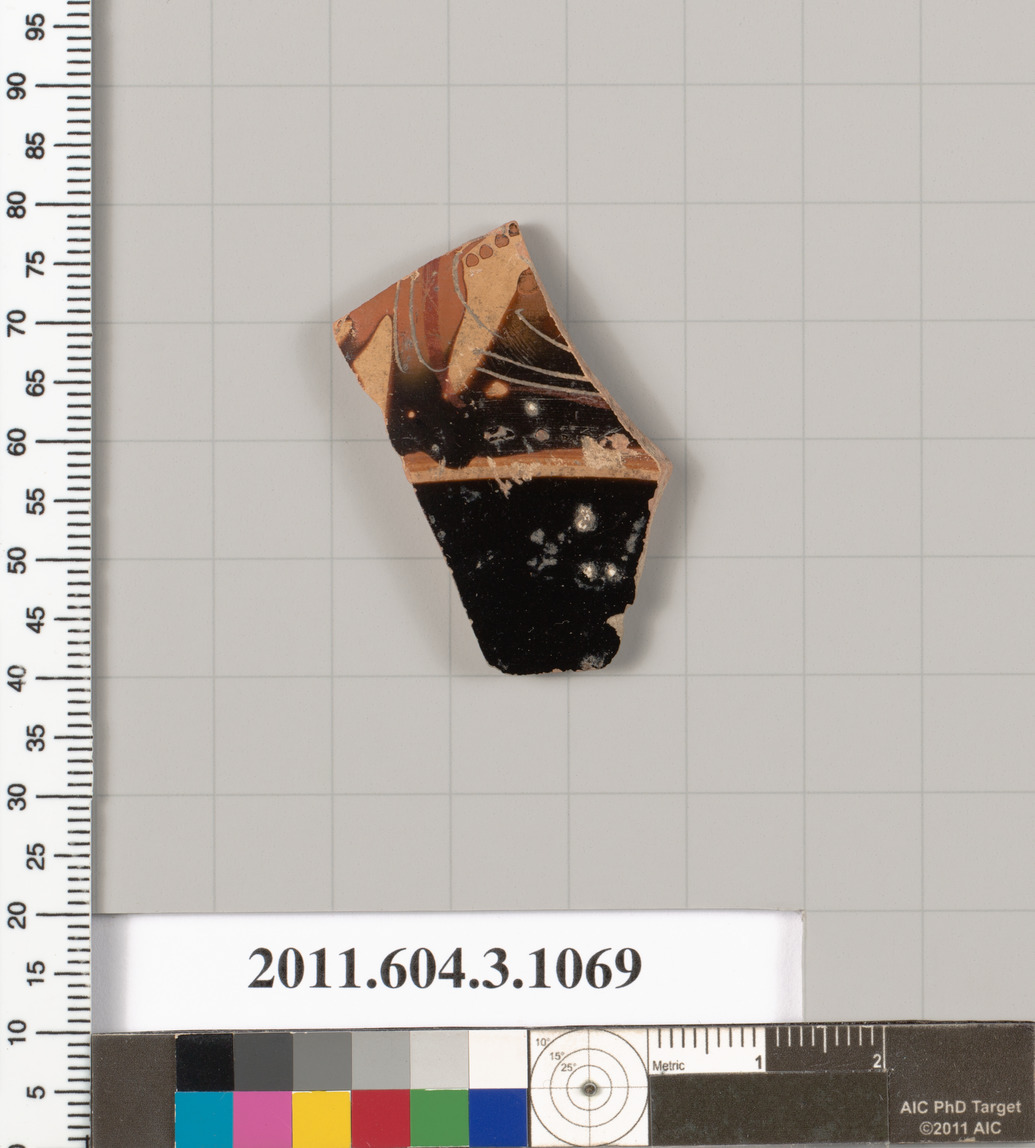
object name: mastoid fragment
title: Terracotta fragment of a mastoid (drinking cup with narrow base)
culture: greek, attic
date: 534-468 BCE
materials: terracotta